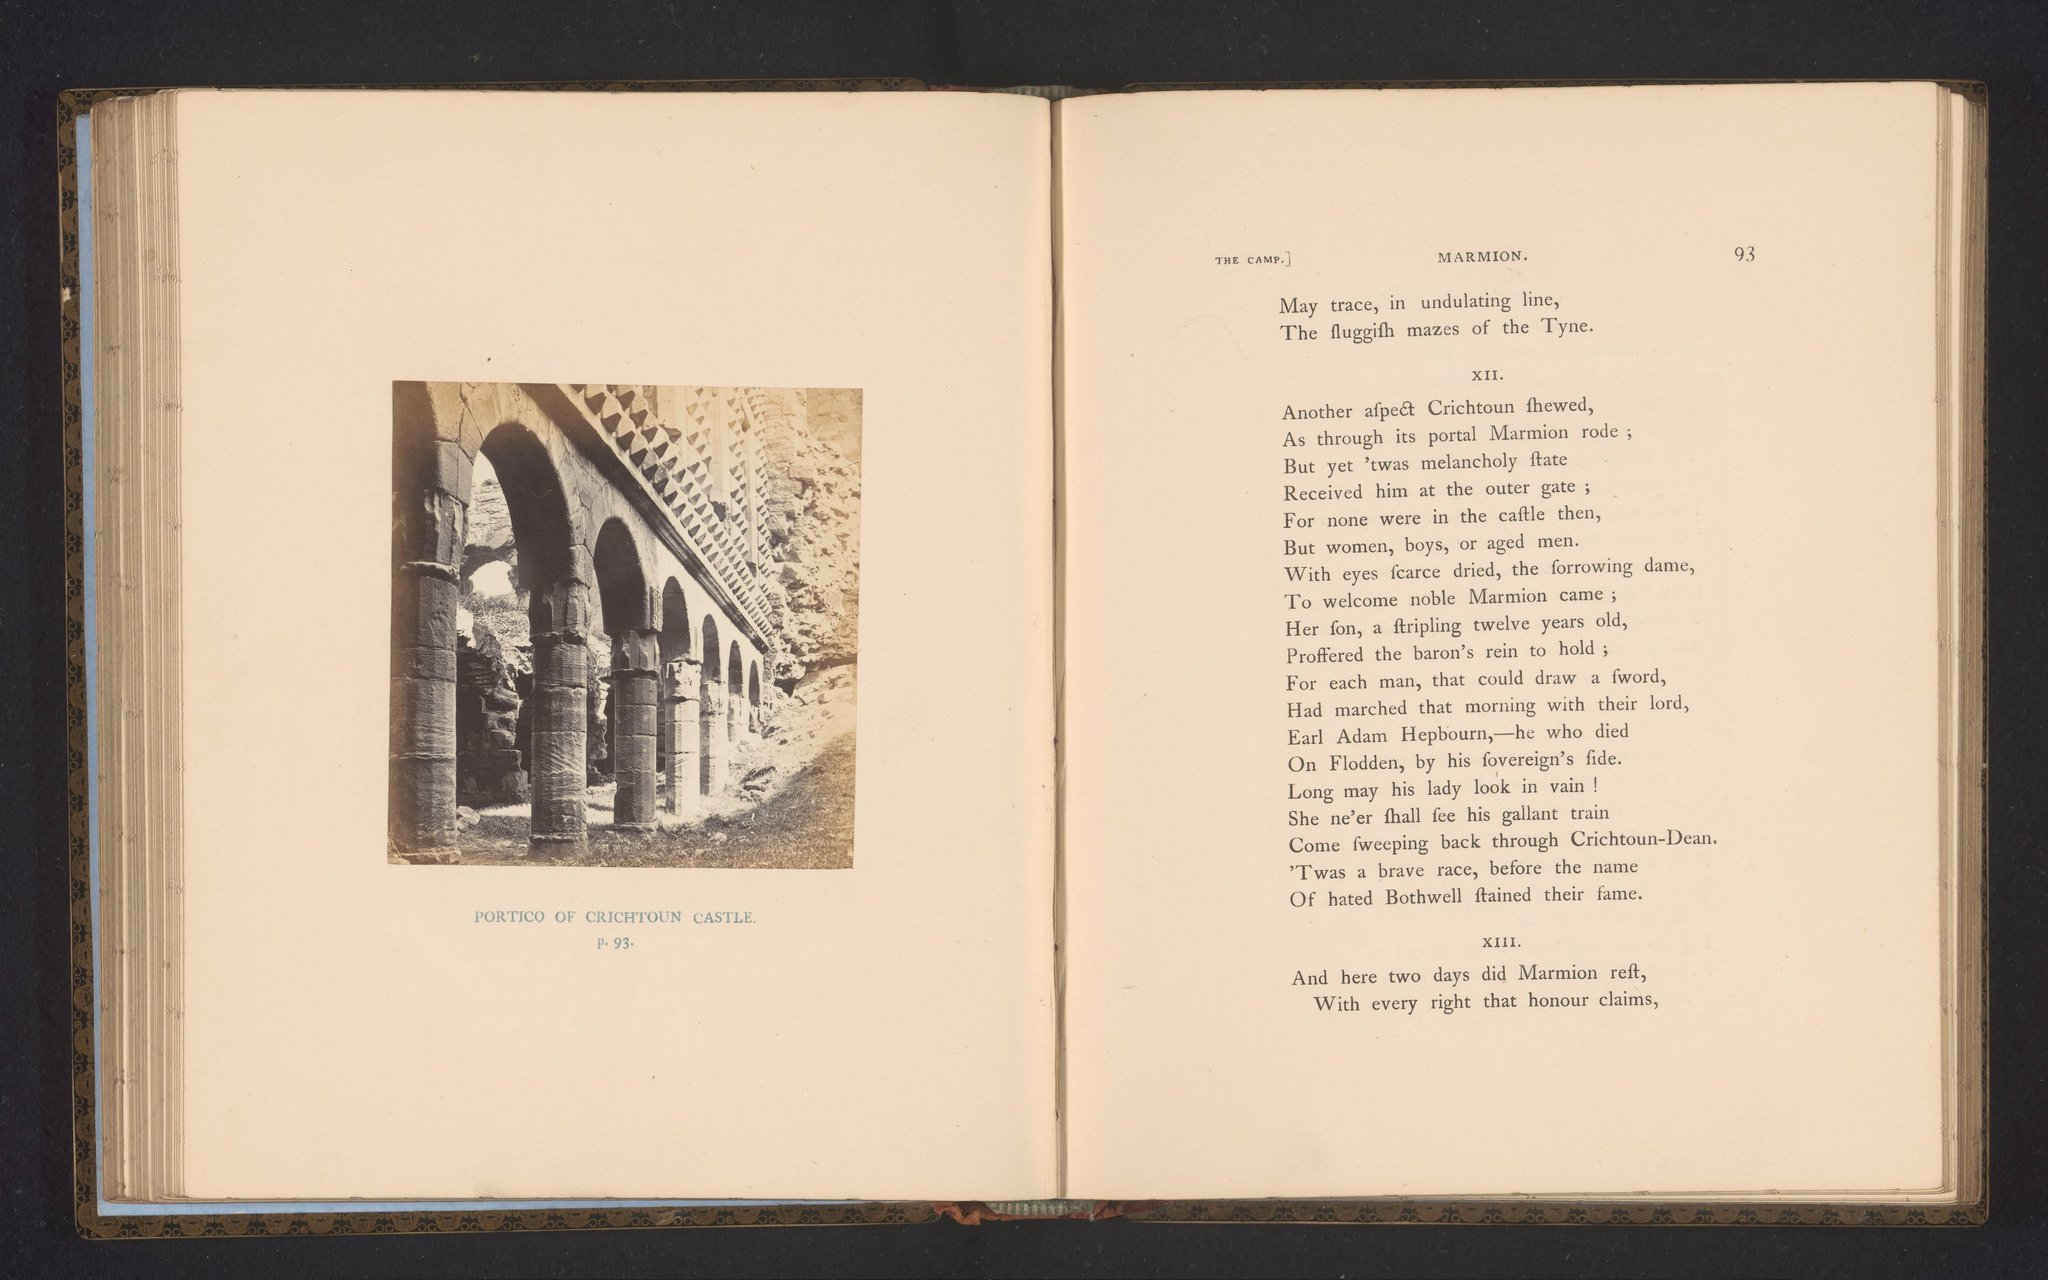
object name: photograph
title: Crichtoun Castle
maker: thomas annan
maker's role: fotograaf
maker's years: 1829-1887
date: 1856-1866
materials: photographic support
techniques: albumen print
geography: midlothian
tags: arcade ~ architecture, ruin of a dwelling, house, castle, etc.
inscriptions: inscription: ‘p. 93.’